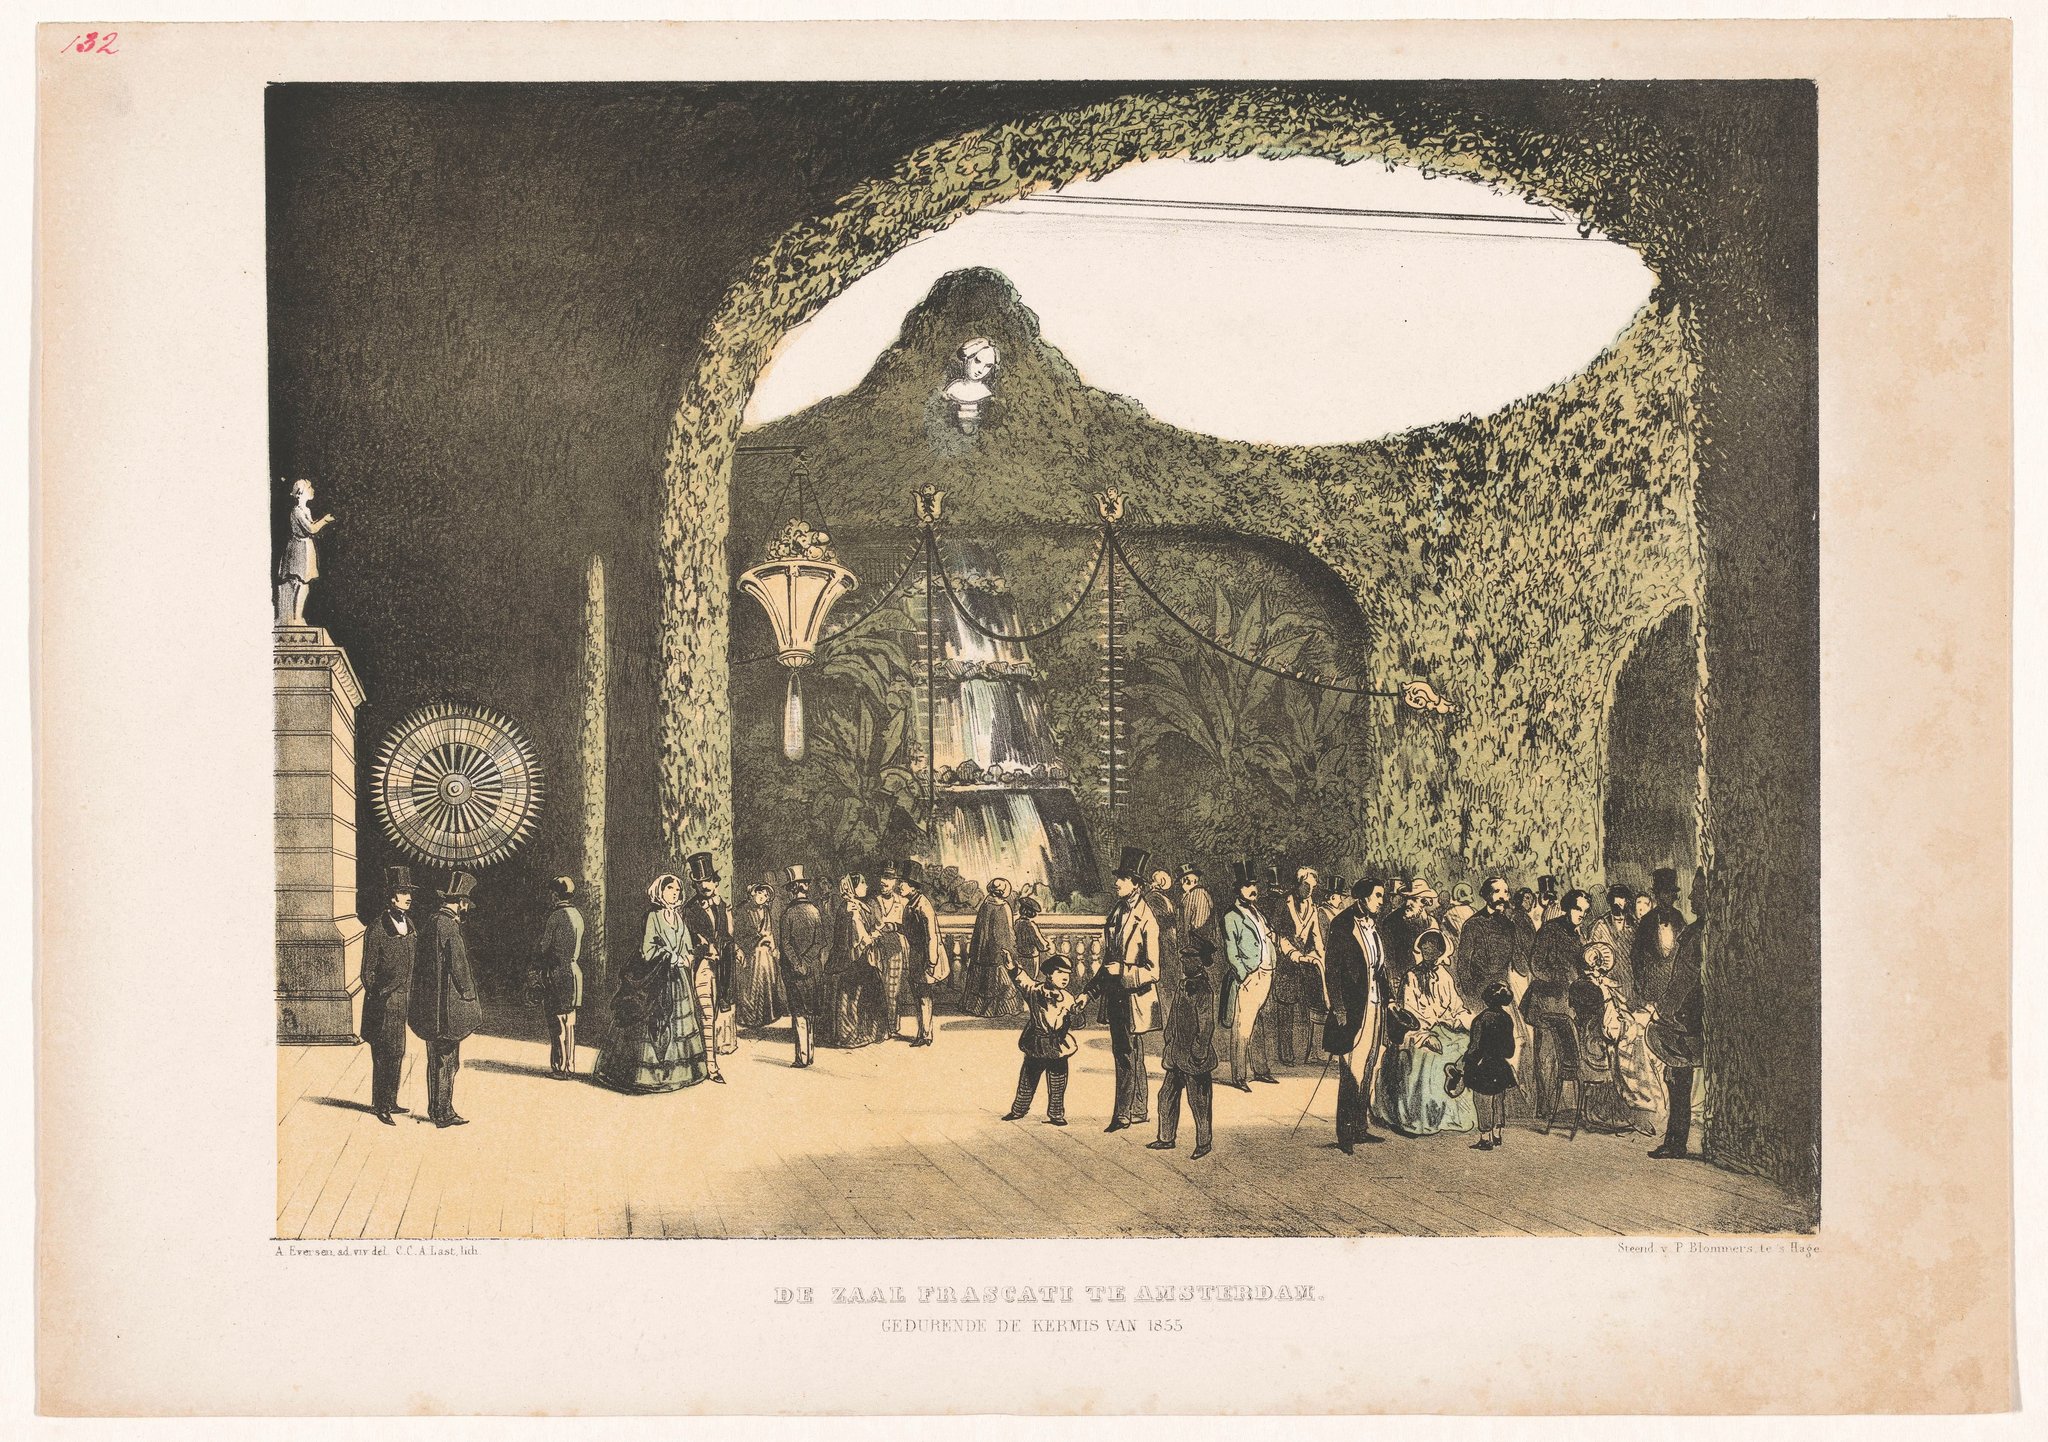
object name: print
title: De zaal Frascati te Amsterdam gedurende de kermis van 1855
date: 1855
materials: paper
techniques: lithograph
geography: the hague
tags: club, meeting place, garden, waterfall, statues, sculptures in garden, amsterdam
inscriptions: collector's mark: Lugt 2233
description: De wanden van de zaal zijn bekleed met planten als ware het een tuin. Tegen de achterwand een waterval. Links een sokkel met een sculptuur en een rad. In het midden hangt een slinger met verlichting. Door de zaal wandelen heren, dames en kinderen.